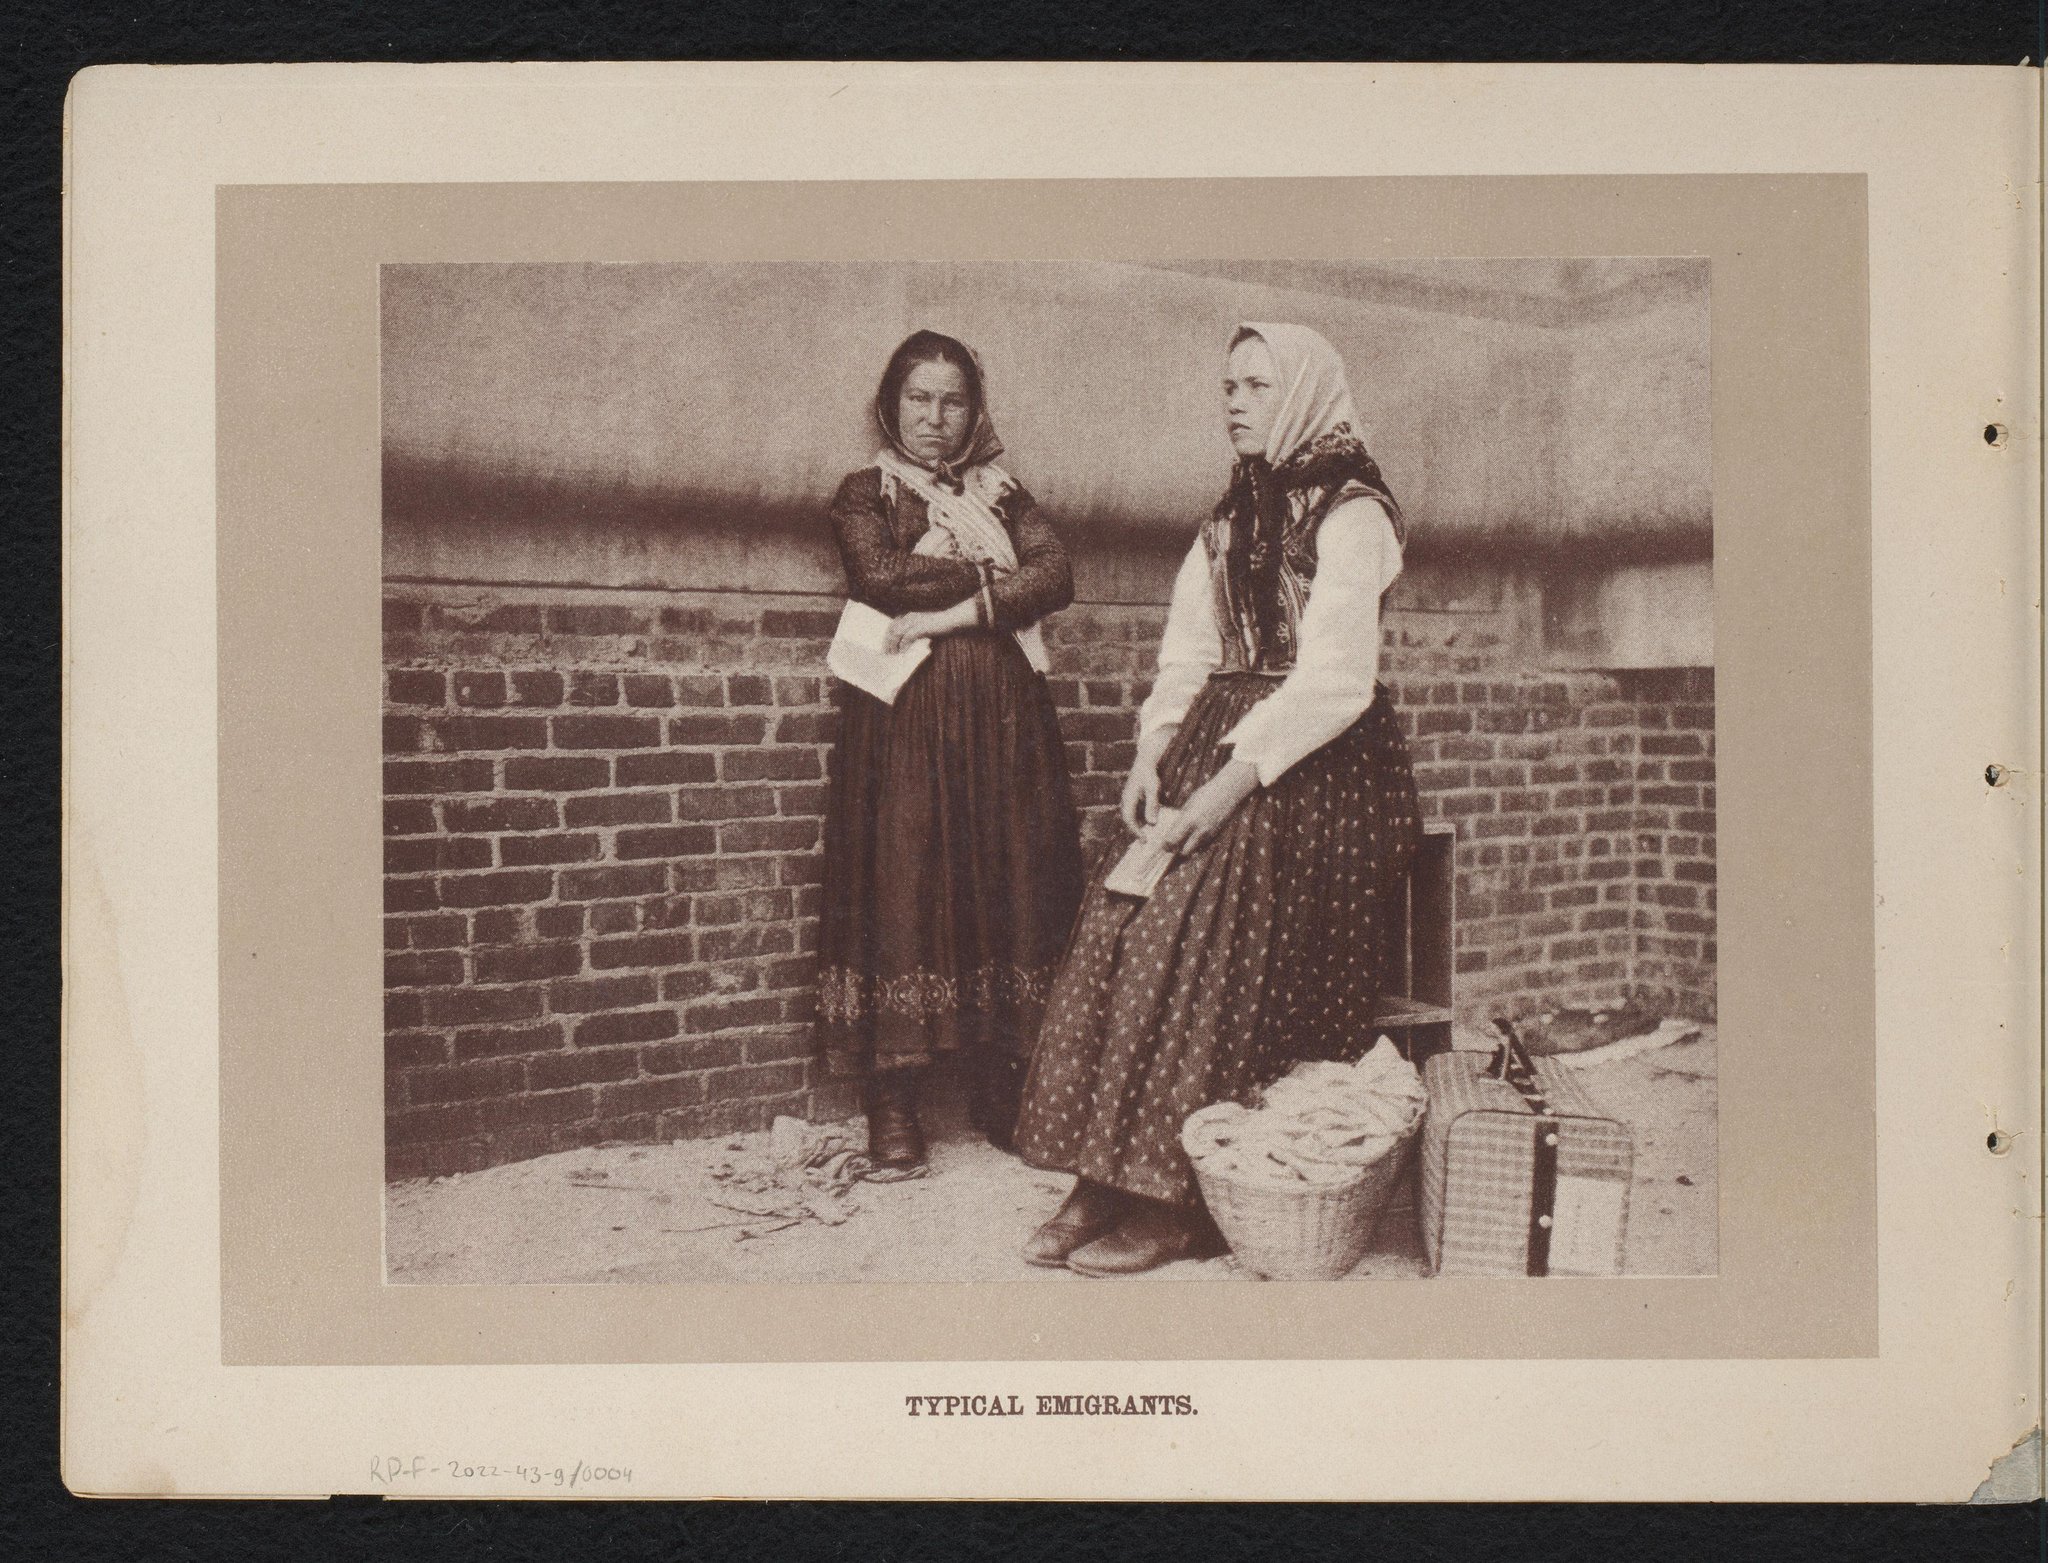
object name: page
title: Typical emigrants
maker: Anonymous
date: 1897-1902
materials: paper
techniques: autotype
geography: new york city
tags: historical persons not known by name - bb - woman, (descendants of) european emigrants to america